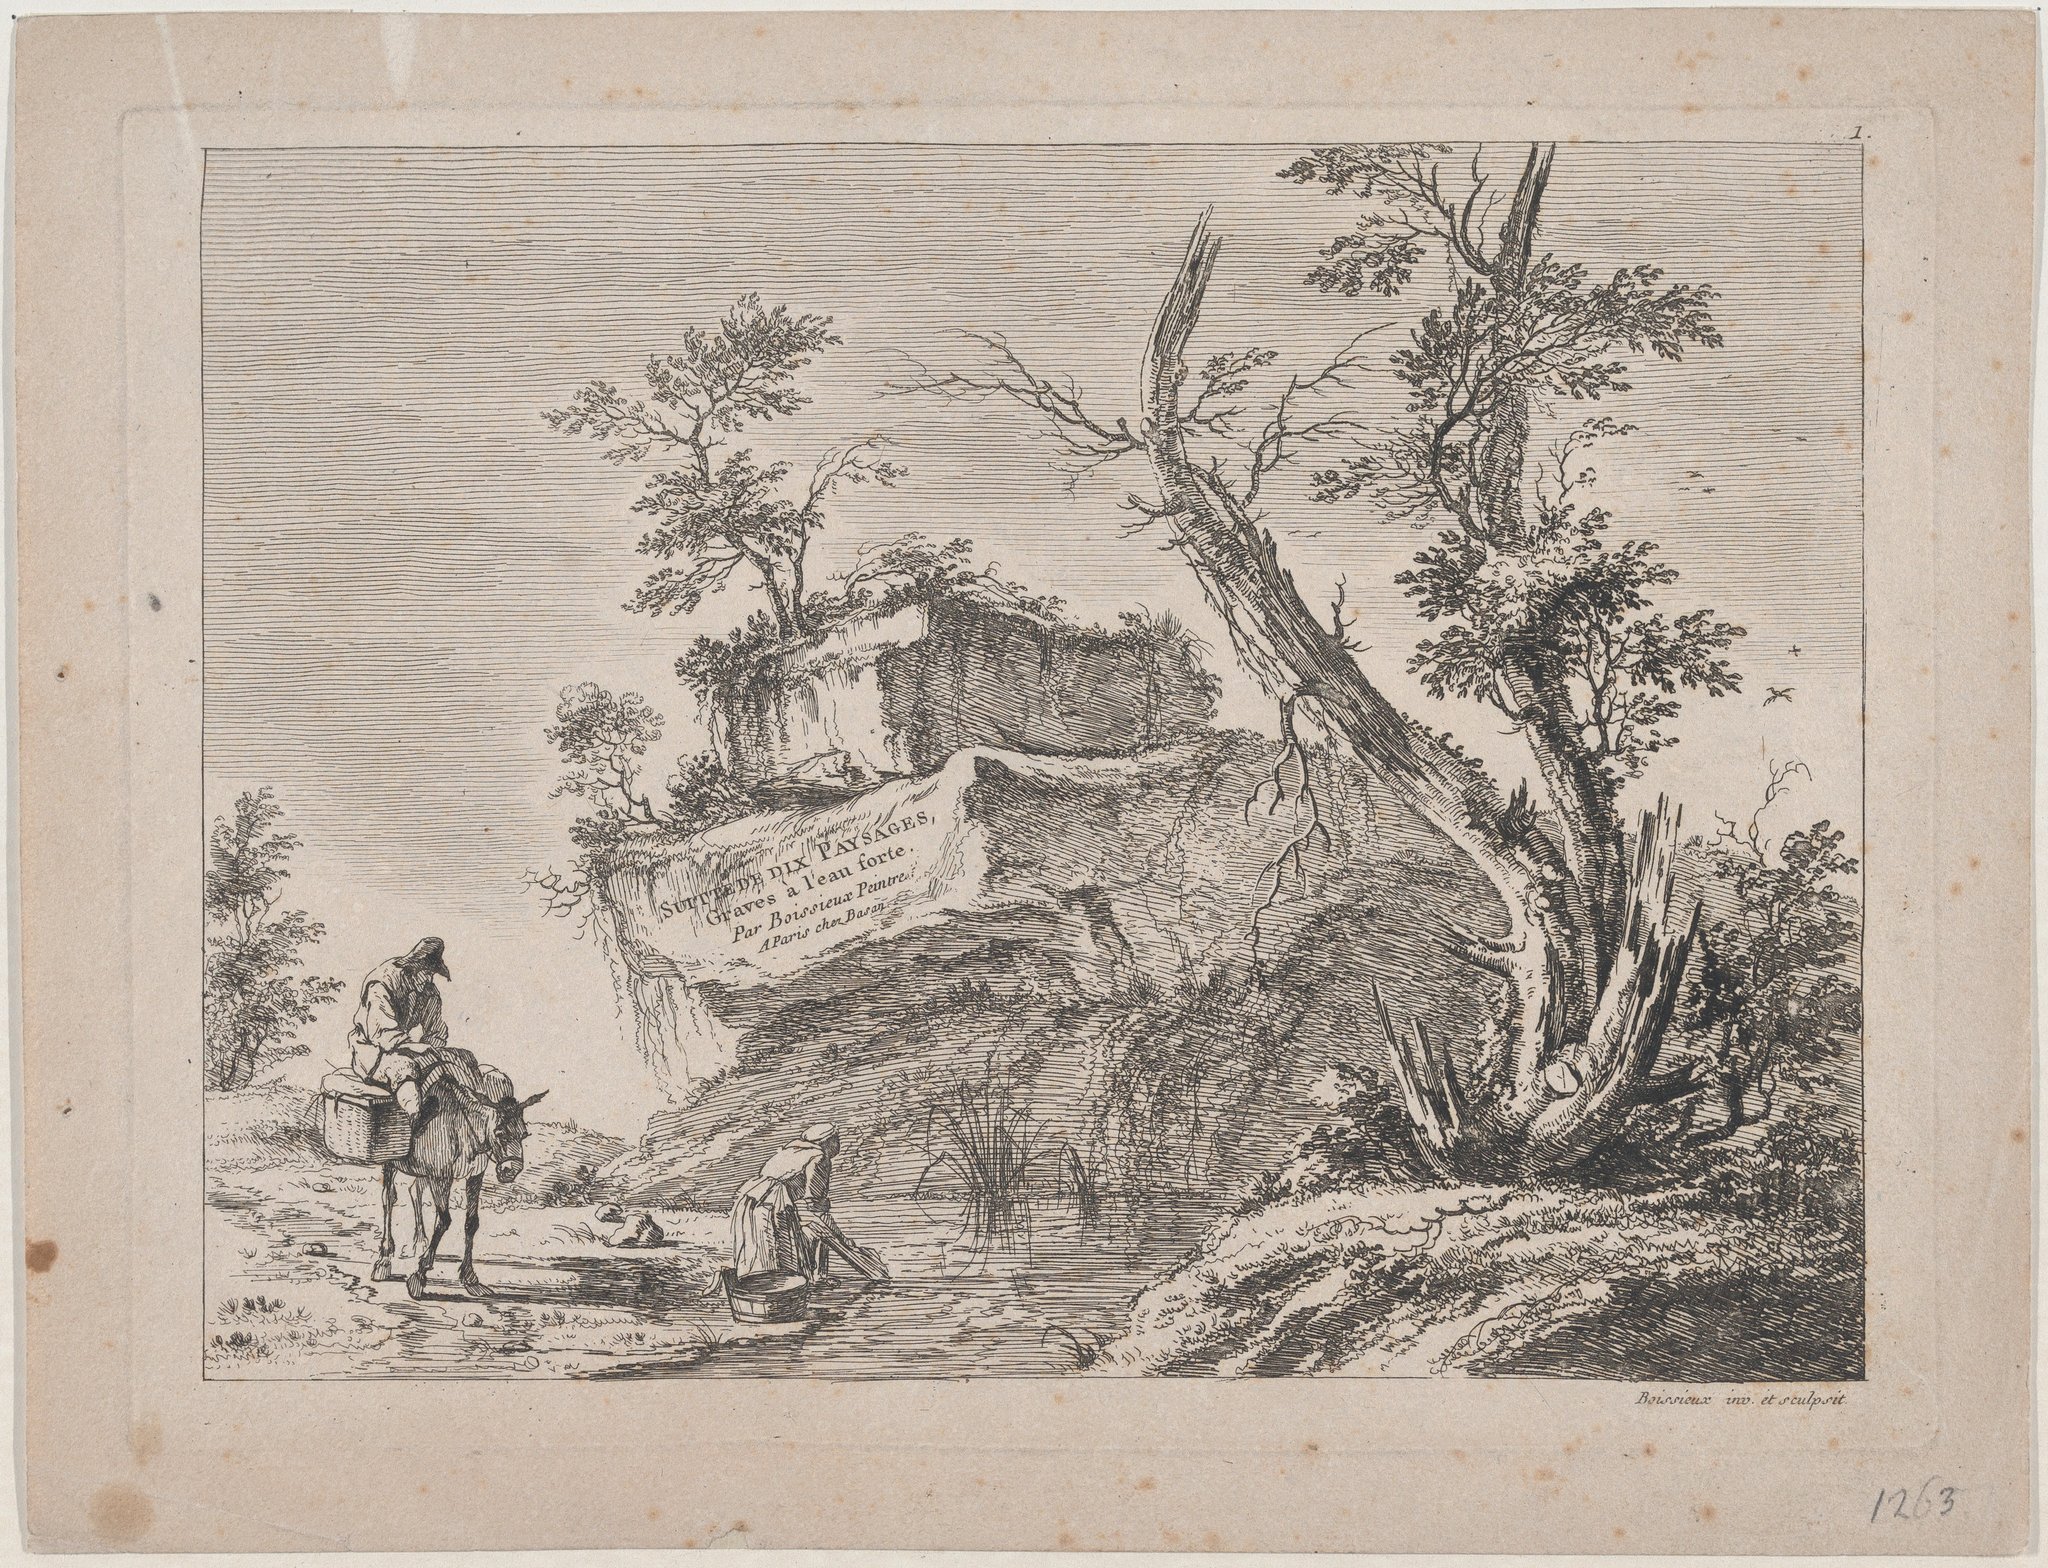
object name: print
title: Title-Page to a Series of Ten Landscapes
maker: jean jacques de boissieu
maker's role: artist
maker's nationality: french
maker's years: 1736-1810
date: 1763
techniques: etching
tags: men,women,donkeys,landscapes